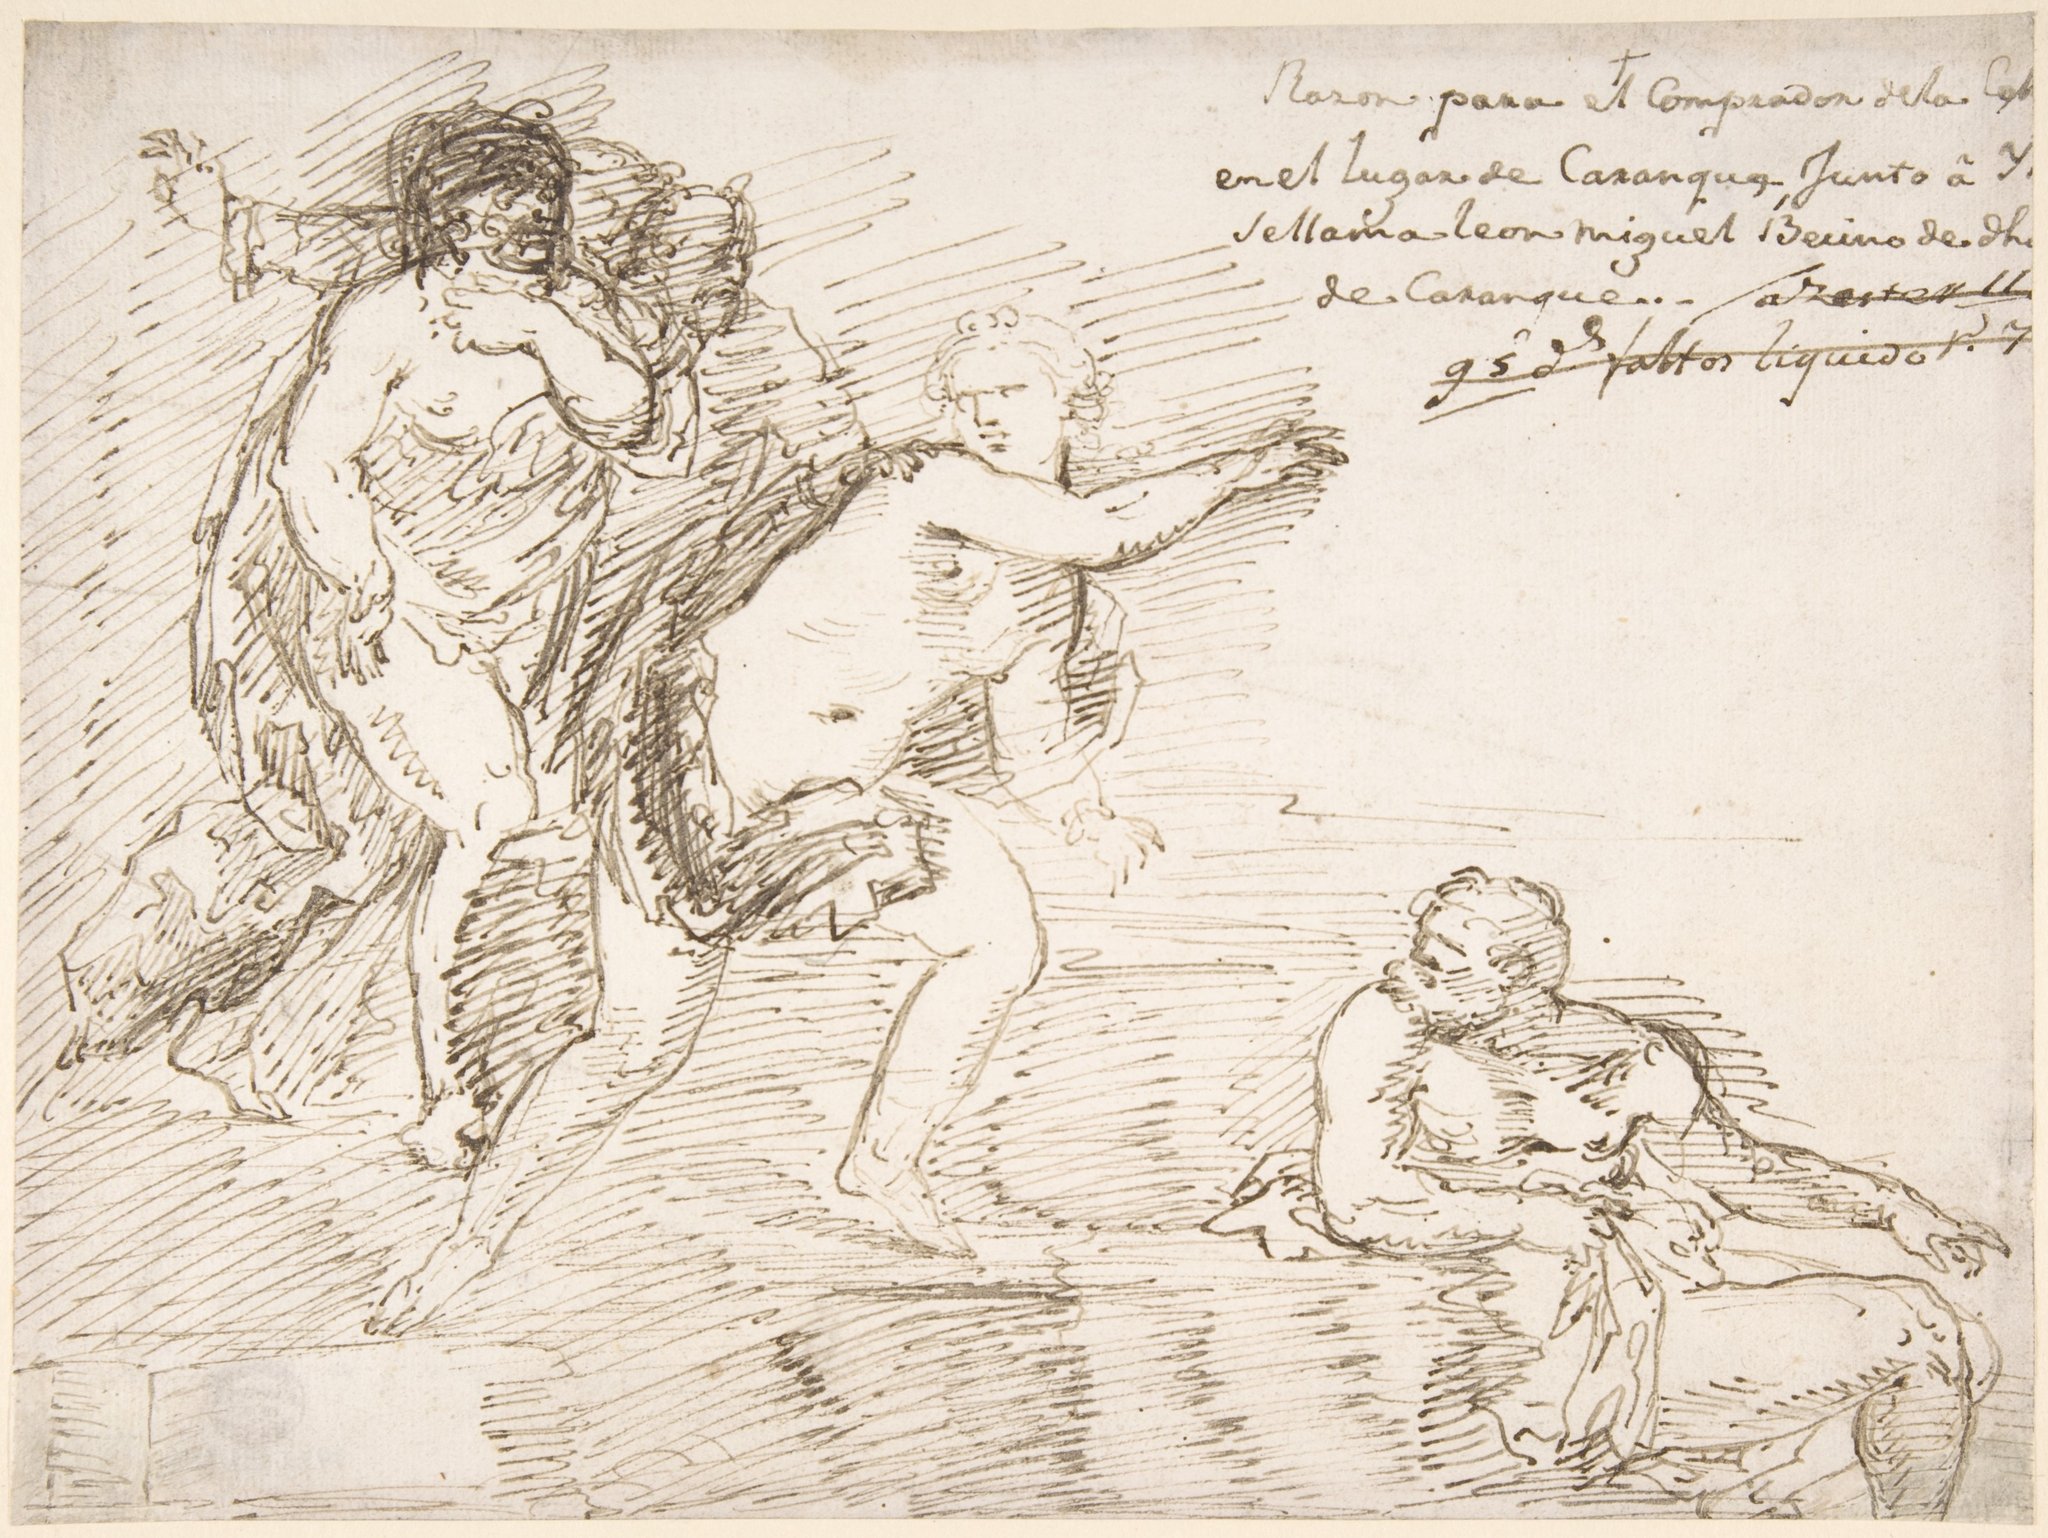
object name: drawing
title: Unidentified Subject with Male Nudes at Left and Right, with a Female Nude at Center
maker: anonymous, spanish, 17th century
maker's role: artist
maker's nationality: spanish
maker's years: 1600-1700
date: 1601-1700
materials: ink, paper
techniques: pen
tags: male nudes,female nudes